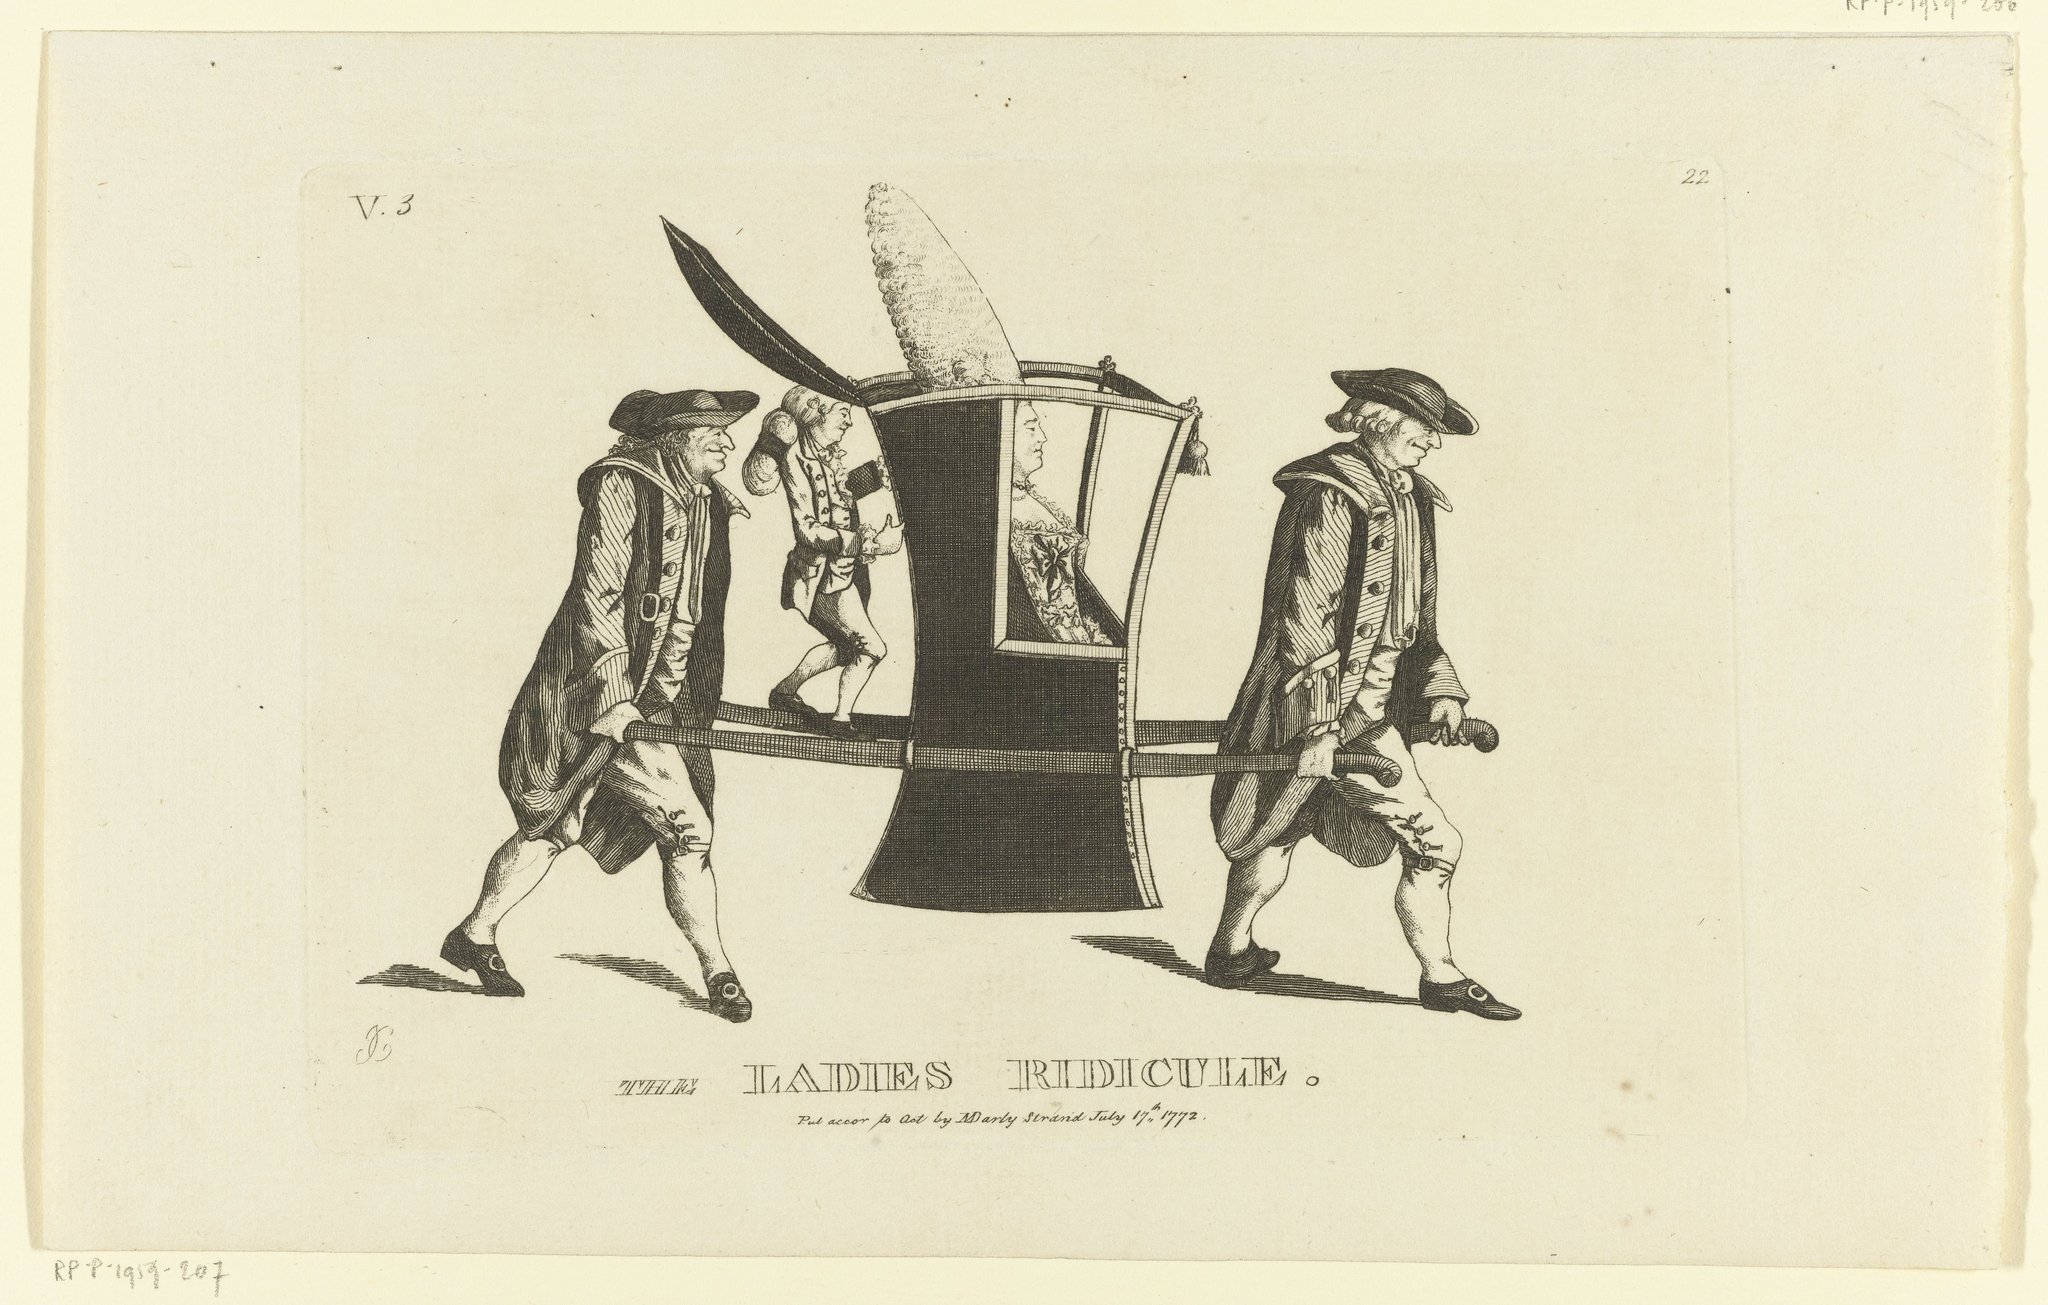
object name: cartoon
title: The Ladies Ridicule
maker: matthew darly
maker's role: print maker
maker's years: 1720-1780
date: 1772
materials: paper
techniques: etching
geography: london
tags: clothing for the upper part of the body (+ women's clothes), human strength ~ traffic and transport on land, excessive hairiness - aa - female, coat (+ men's clothes), head-gear: hat (+ men's clothes), trousers, breeches, etc. (breeches) (+ men's clothes)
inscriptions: caption: ‘THE LADIES RIDICULE. / Pub accor to Act by MDarly Strand July 17th 1772’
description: Een Engelse vrouw met een torenhoog kapsel wordt in een draagkoets vervoerd. Vanwege het hoge kapsel is het dak van de koets opengeklapt. Linksboven V. 3; rechtsboven nummer 22. Engelse caricaturen uit de serie 'Macaronies' uitgegeven door D. Marly in 1771 en 1772.